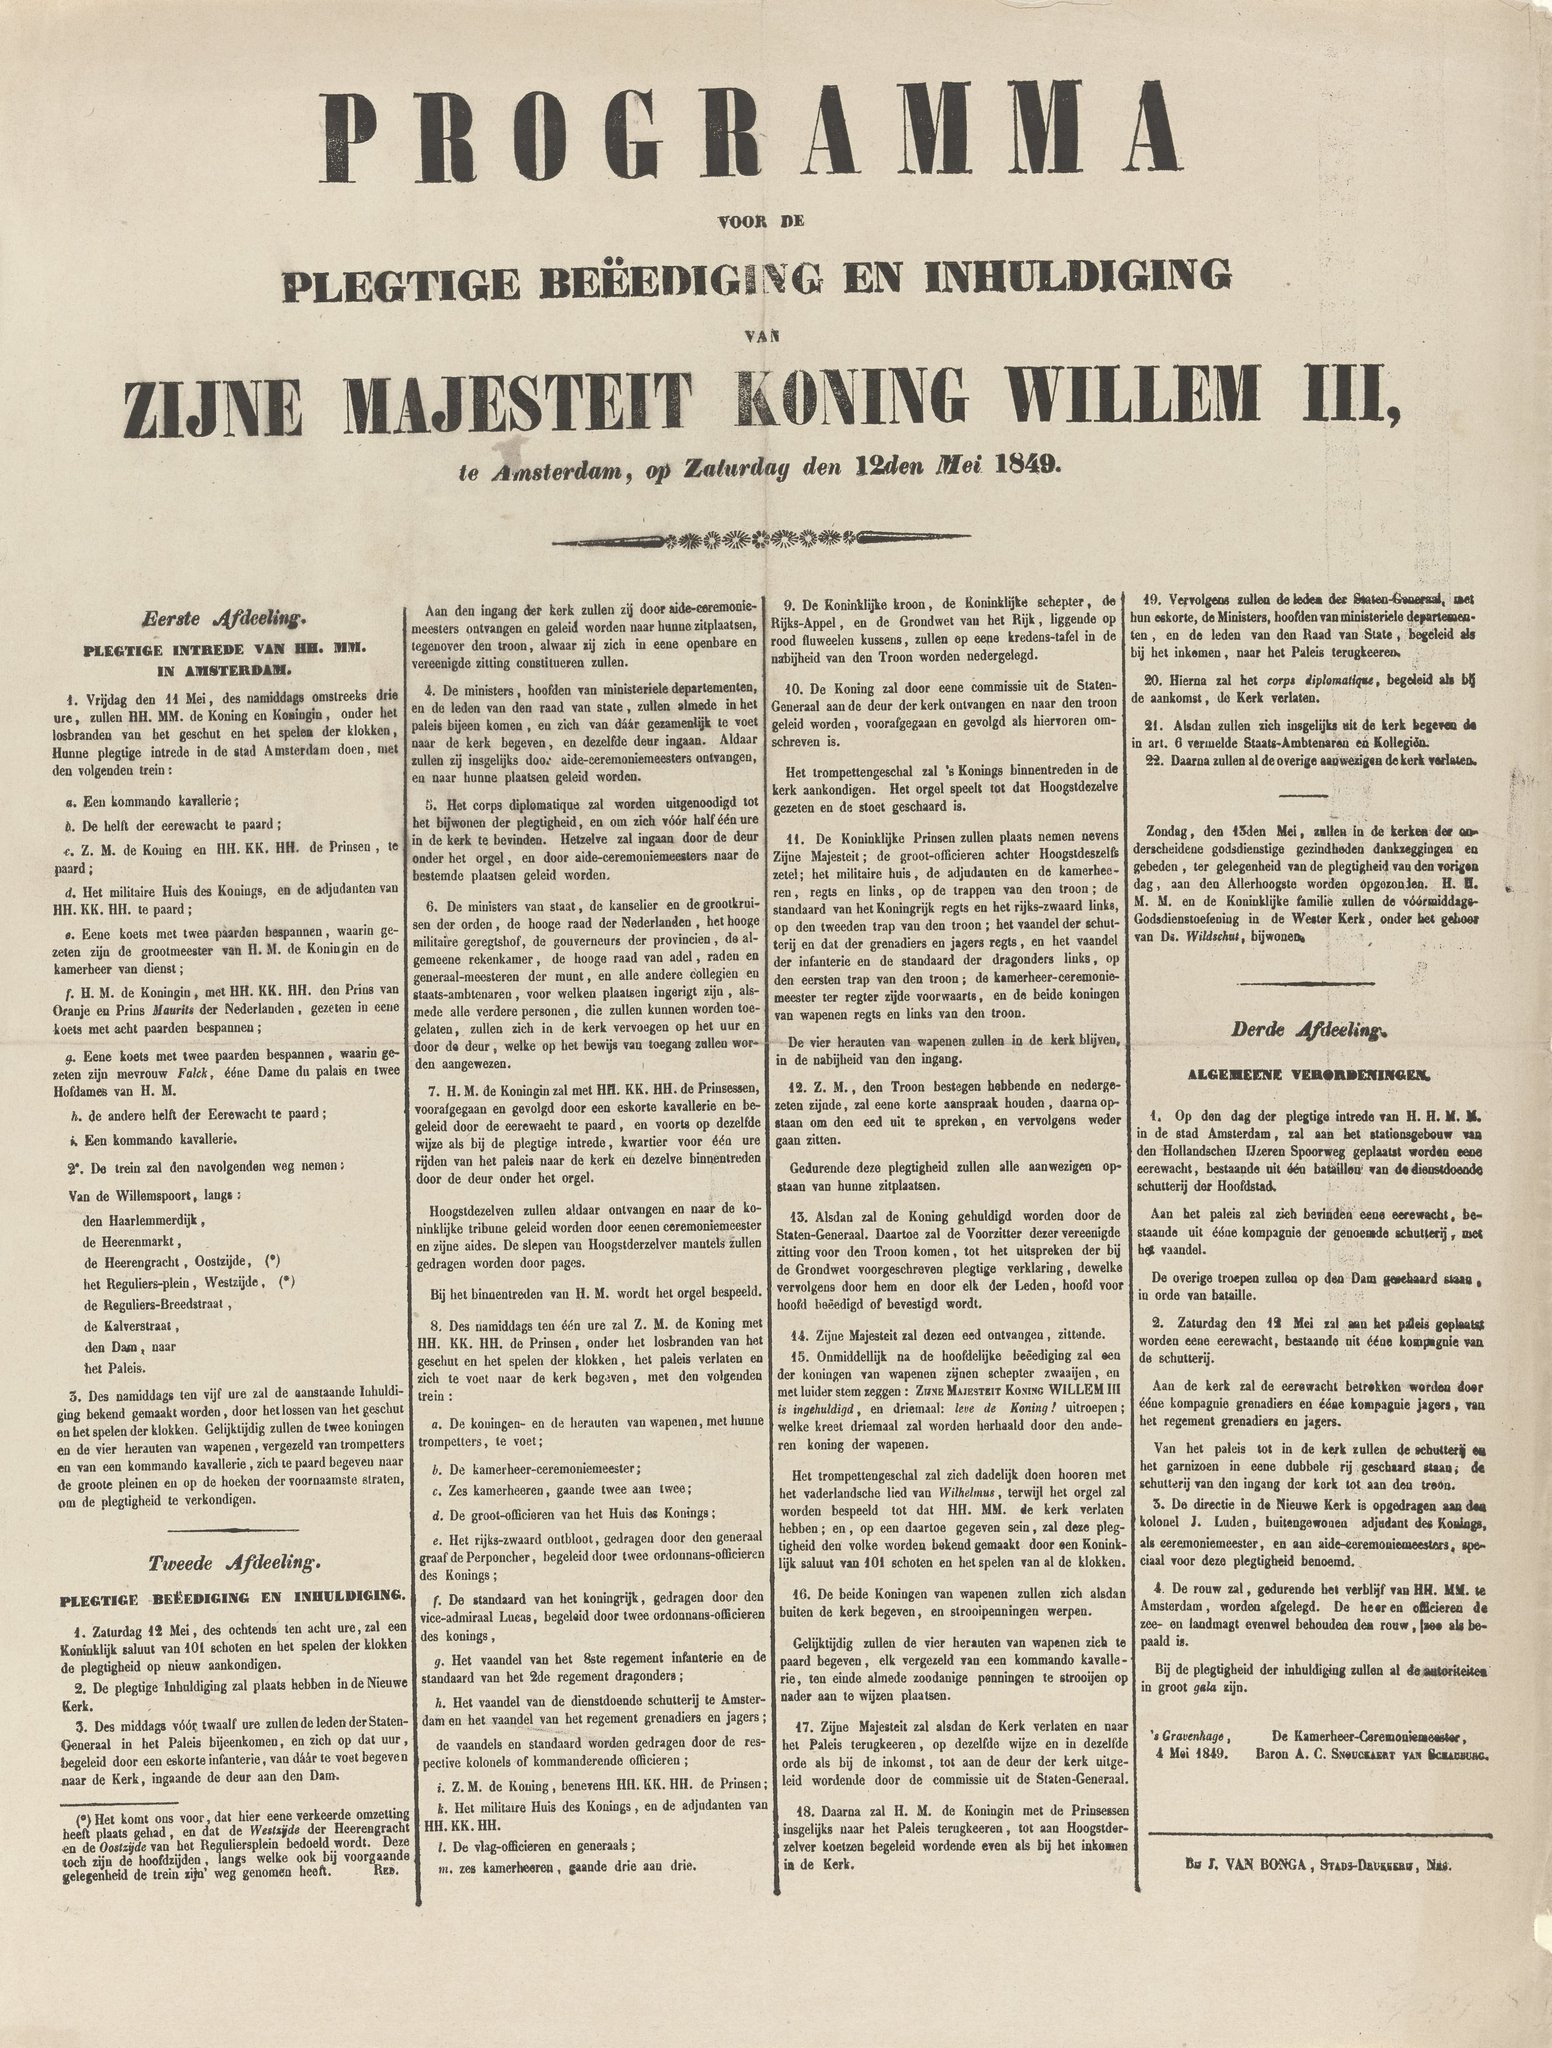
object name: programma, programmaboekje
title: Programma voor de Plegtige Beëediging en Inhuldiging van Zijne Majesteit Koning Willem III, te Amsterdam, op Zaturdag den 12den Mei 1849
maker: jacobus van bonga jr.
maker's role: printer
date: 1849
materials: paper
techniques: letterpress printing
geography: amsterdam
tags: willem iii (koning der nederlanden), other forms of installation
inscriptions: collector's mark: Lugt 2228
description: Gedrukte programma van de inhuldiging van koning Willem III in de Nieuwe Kerk te Amsterdam op 12 mei 1849. Blad met tekst in vier kolommen.